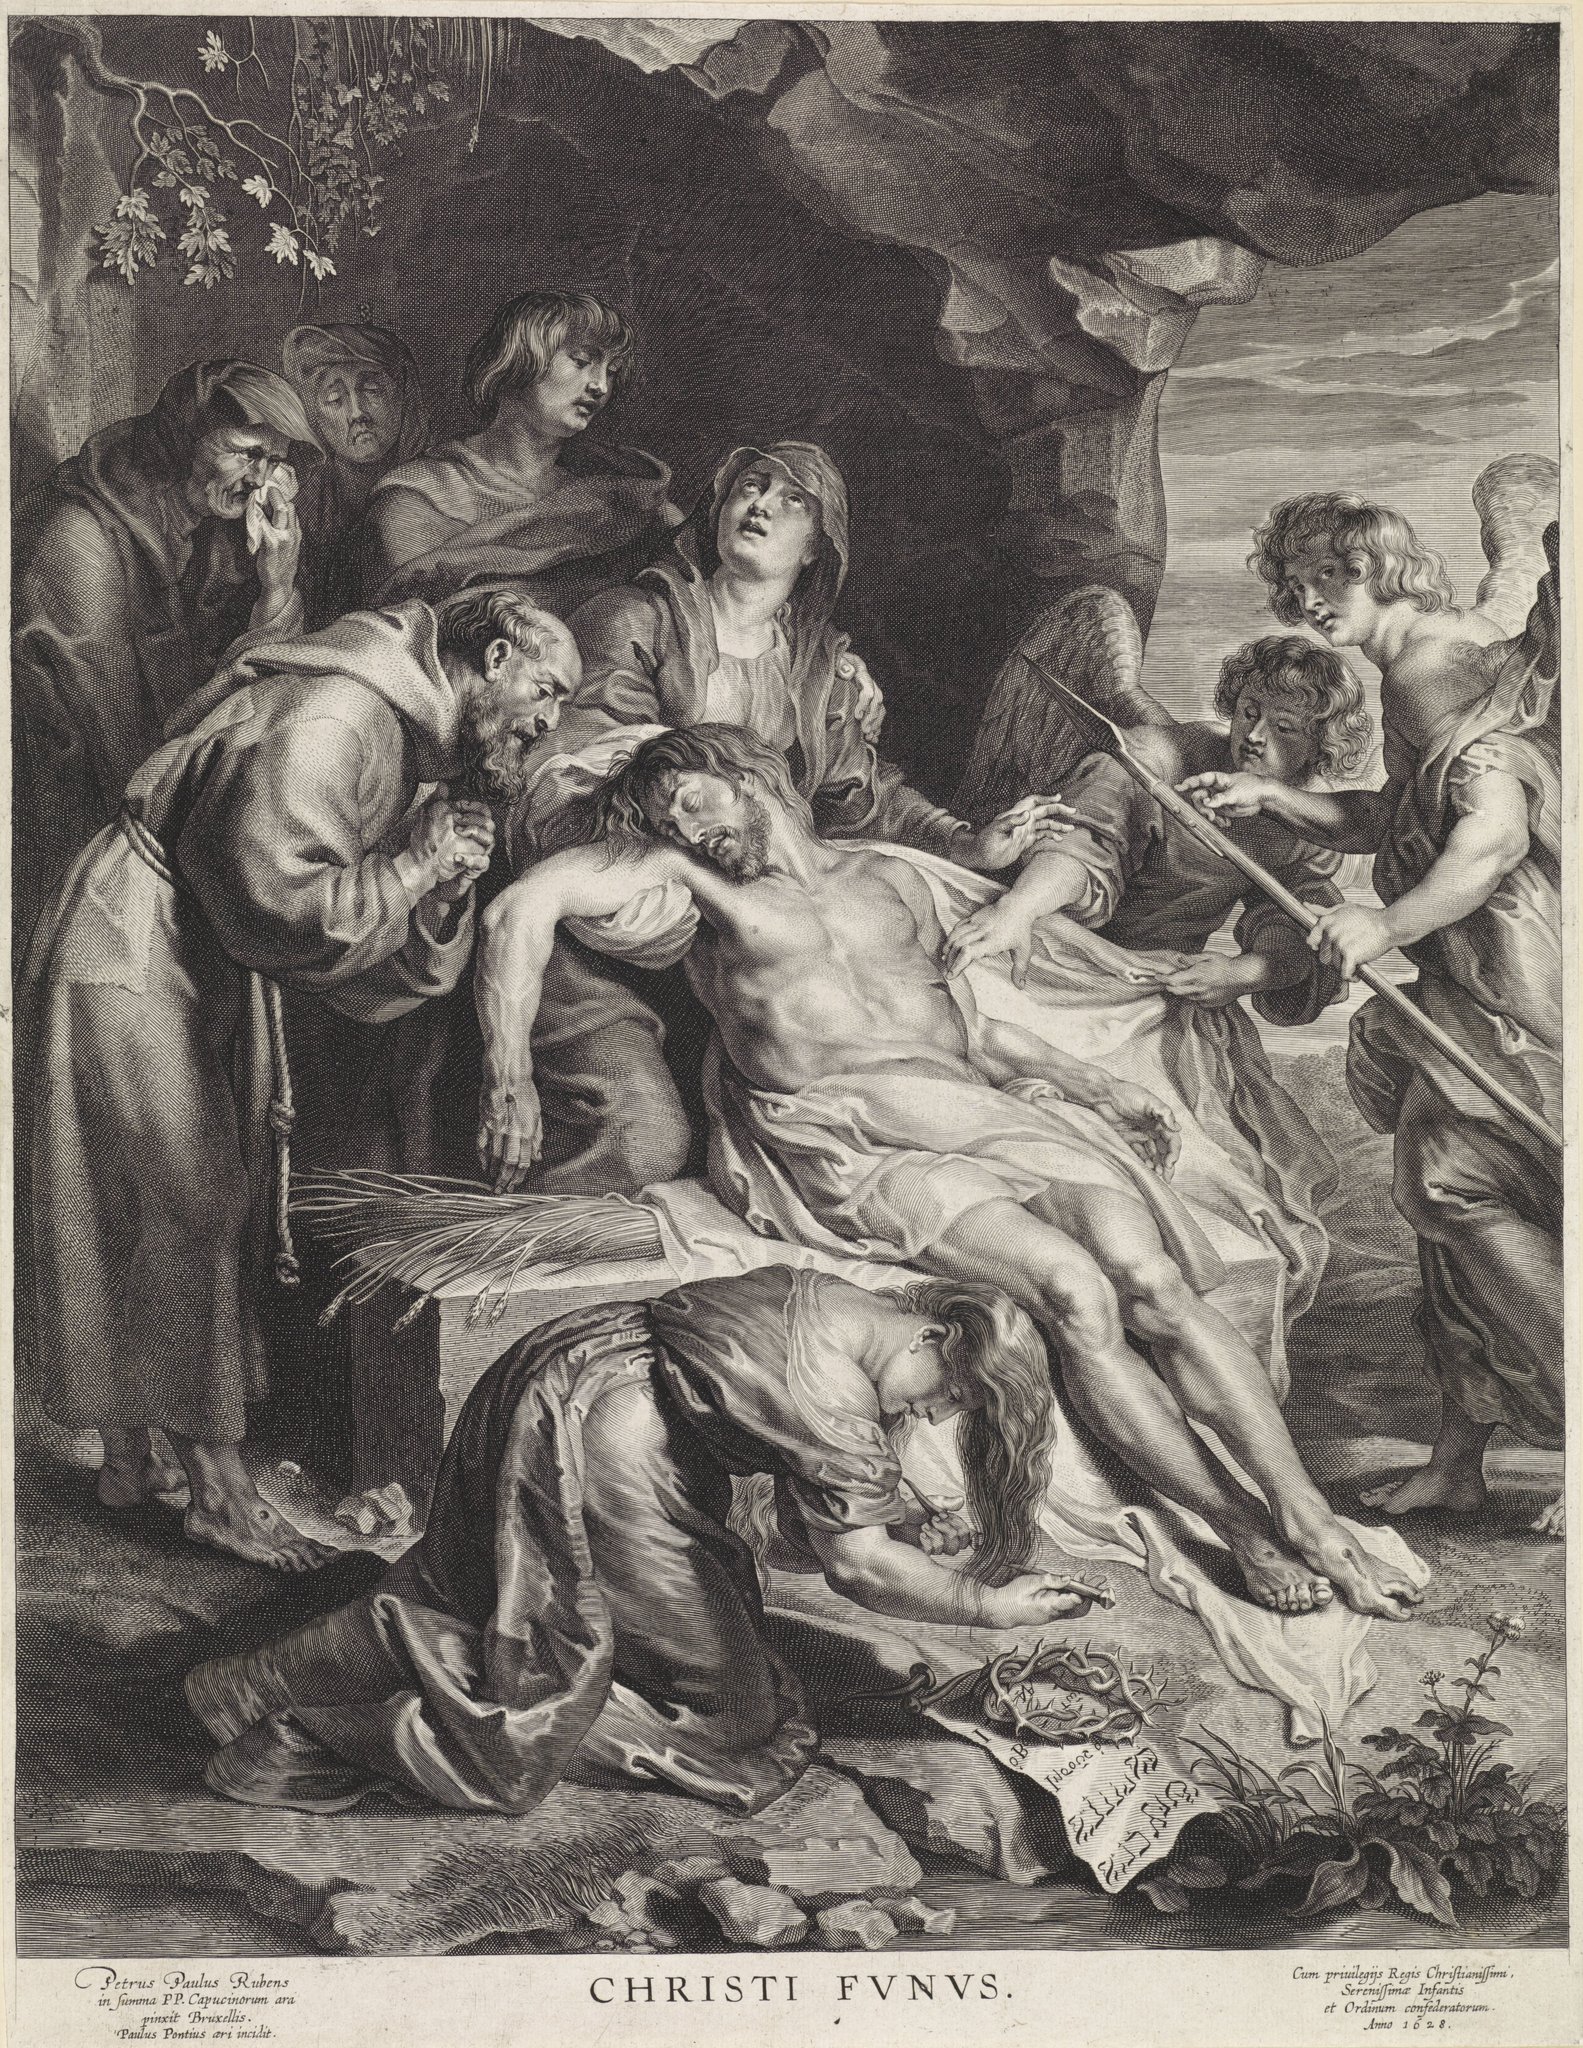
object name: print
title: Graflegging van Christus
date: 1628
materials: paper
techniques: engraving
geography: brussels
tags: lamentation over the dead christ by his relatives and friends (christ usually without crown of thorns)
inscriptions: collector's mark: Lugt 240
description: Christus ligt in zijn graf. Achter hem staan Maria, Franciscus van Assisi en Johannes de Doper. Aan zijn voeten knielt Maria Magdalena. Rechts twee engelen, van wie één wijst op de wond van Christus.